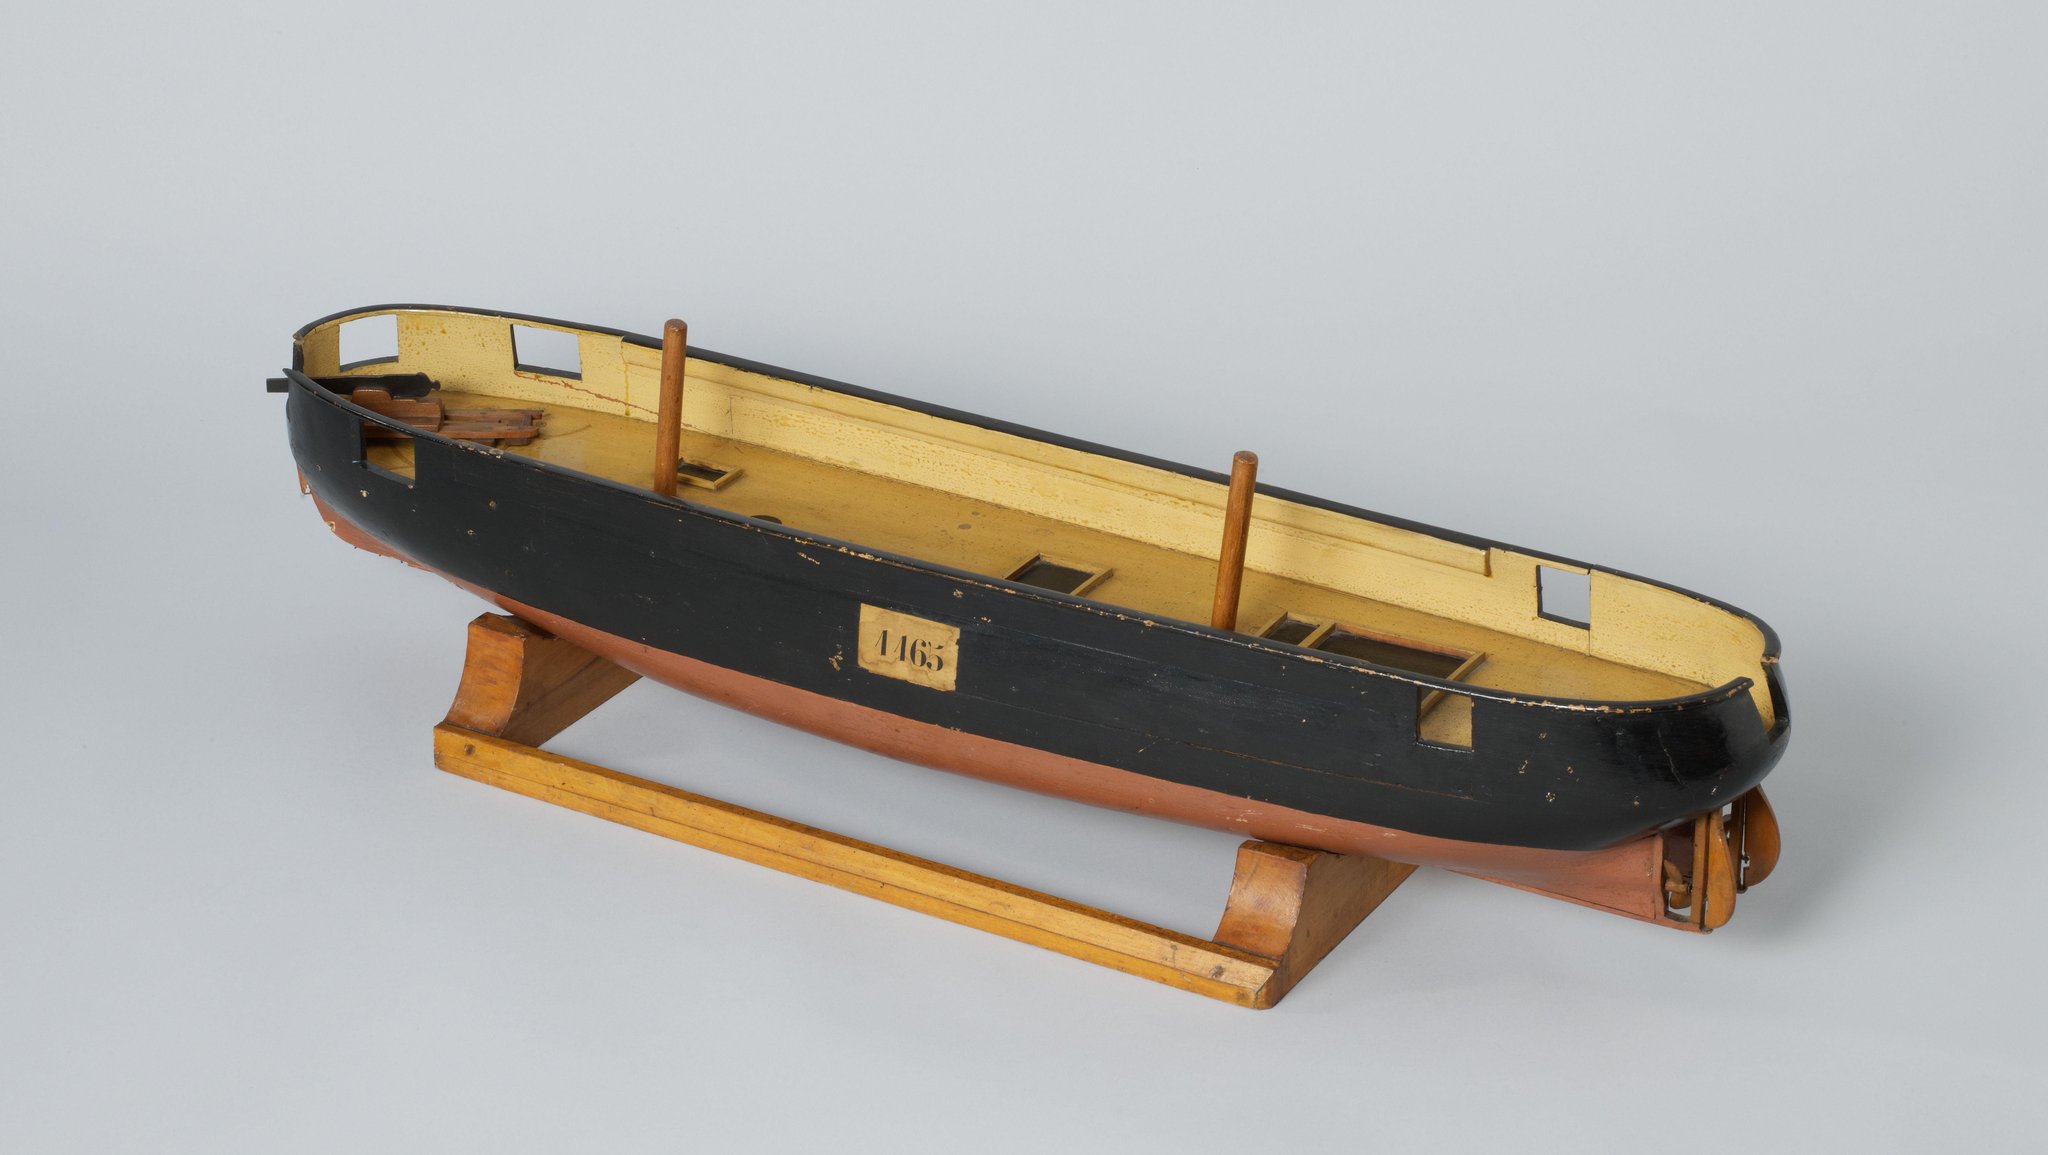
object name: ship model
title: Models of a Twin Screw Steamer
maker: h.g. jansen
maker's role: designer, model maker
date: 1864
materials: brass, wood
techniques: polychromy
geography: netherlands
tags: ship-model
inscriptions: label, on the side: ‘1165’ former inventory label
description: Gepolychromeerd blokmodel van een houten dubbelschroefstoomschip, beschadigd. Het typische aan dit model is het ronde achterschip met twee achterstevens voor de tweebladige schroeven en de twee roeren; hiervoor lopen twee extra kielen van ongeveer halverwege naar de achterstevens. Eén dek met indicatie van luiken. Zeven geschutpoorten en een schematisch model van een kanon op schuifaffuit, met sporen voor zijn posities op het dek. Van de twee masten en de boegspriet zijn slechts delen op het model aangebracht. De voorsteven loopt terug, tegemoetkomend aan de mode van de vroege ramschepen. Schaal 1:40 (afgeleid).